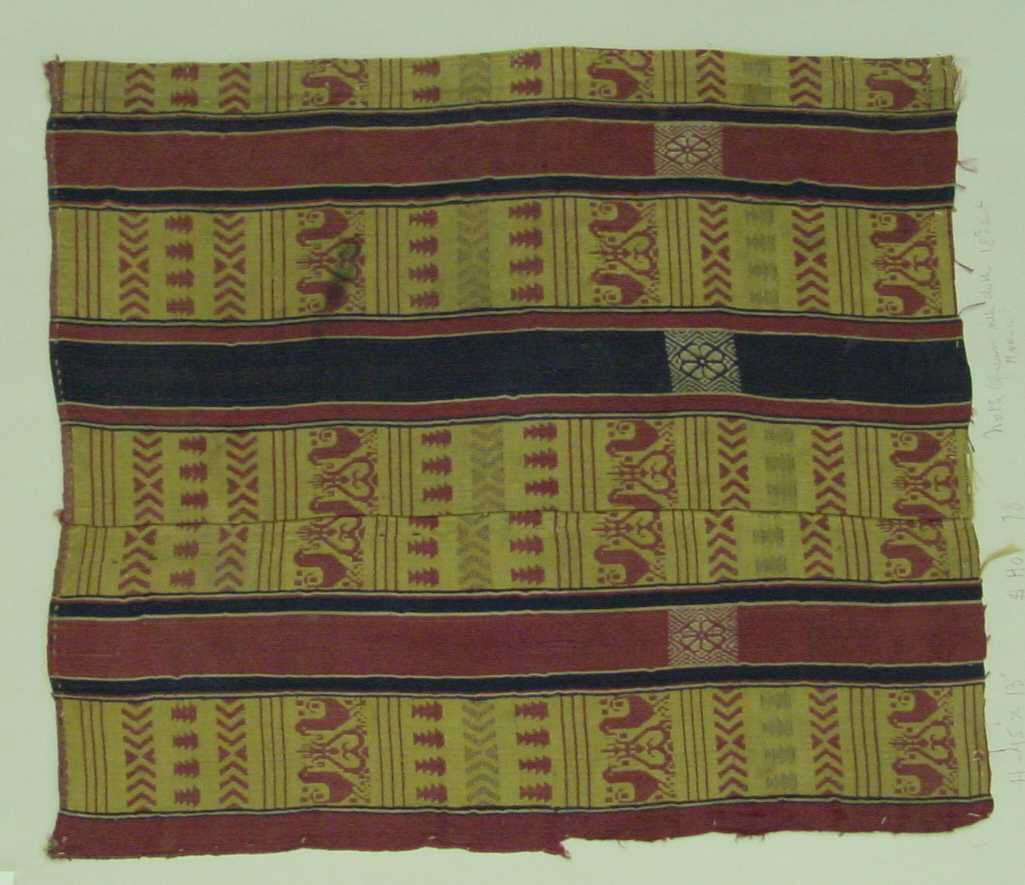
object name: textile fragment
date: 1701-1800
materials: silk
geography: north africa